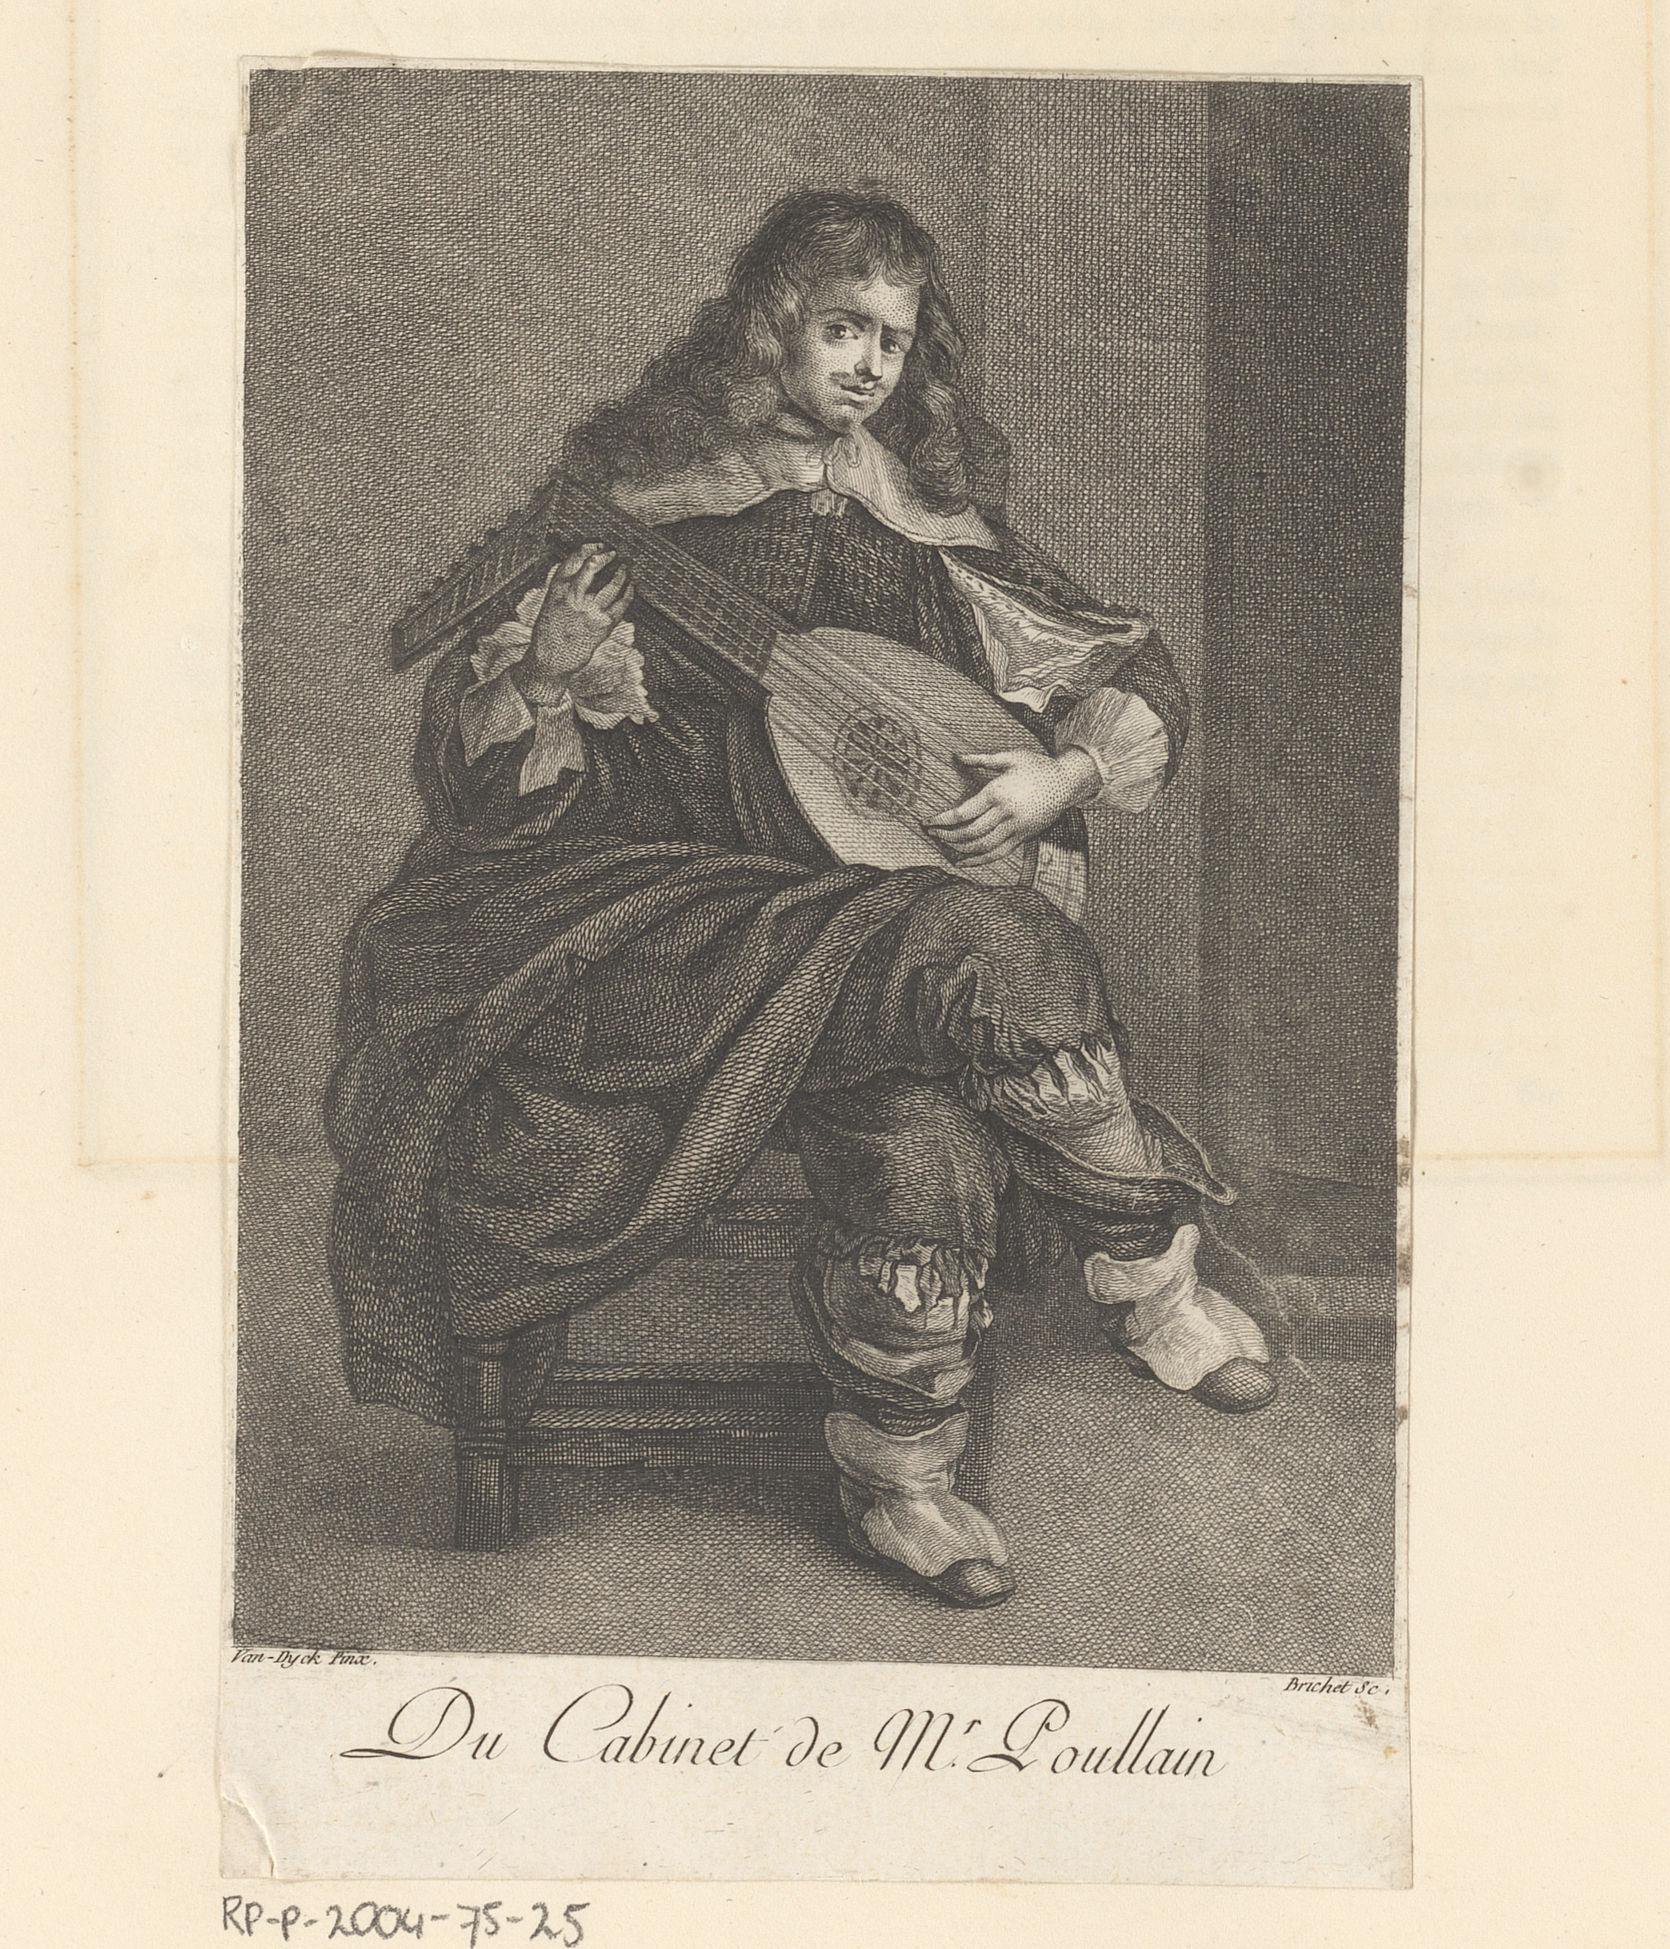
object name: album leaf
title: Collection de cent-vingt estampes gravées d'après les tableaux & dessins qui composoient le Cabinet de M. Poullain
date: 1775-1783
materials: paper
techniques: engraving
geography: paris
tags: one person playing string instrument (plucked), lute, and special forms of lute, e.g.: theorbo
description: De samensteller heeft deze prent in het album geplakt als illustratie bij: Pilkington, Matthew en Johann Heinrich Füssli. A dictionary of painters, from the revival of the art to the present period. 4 dln. Londen: John Crowder, 1805, dl. 4, p. 577.